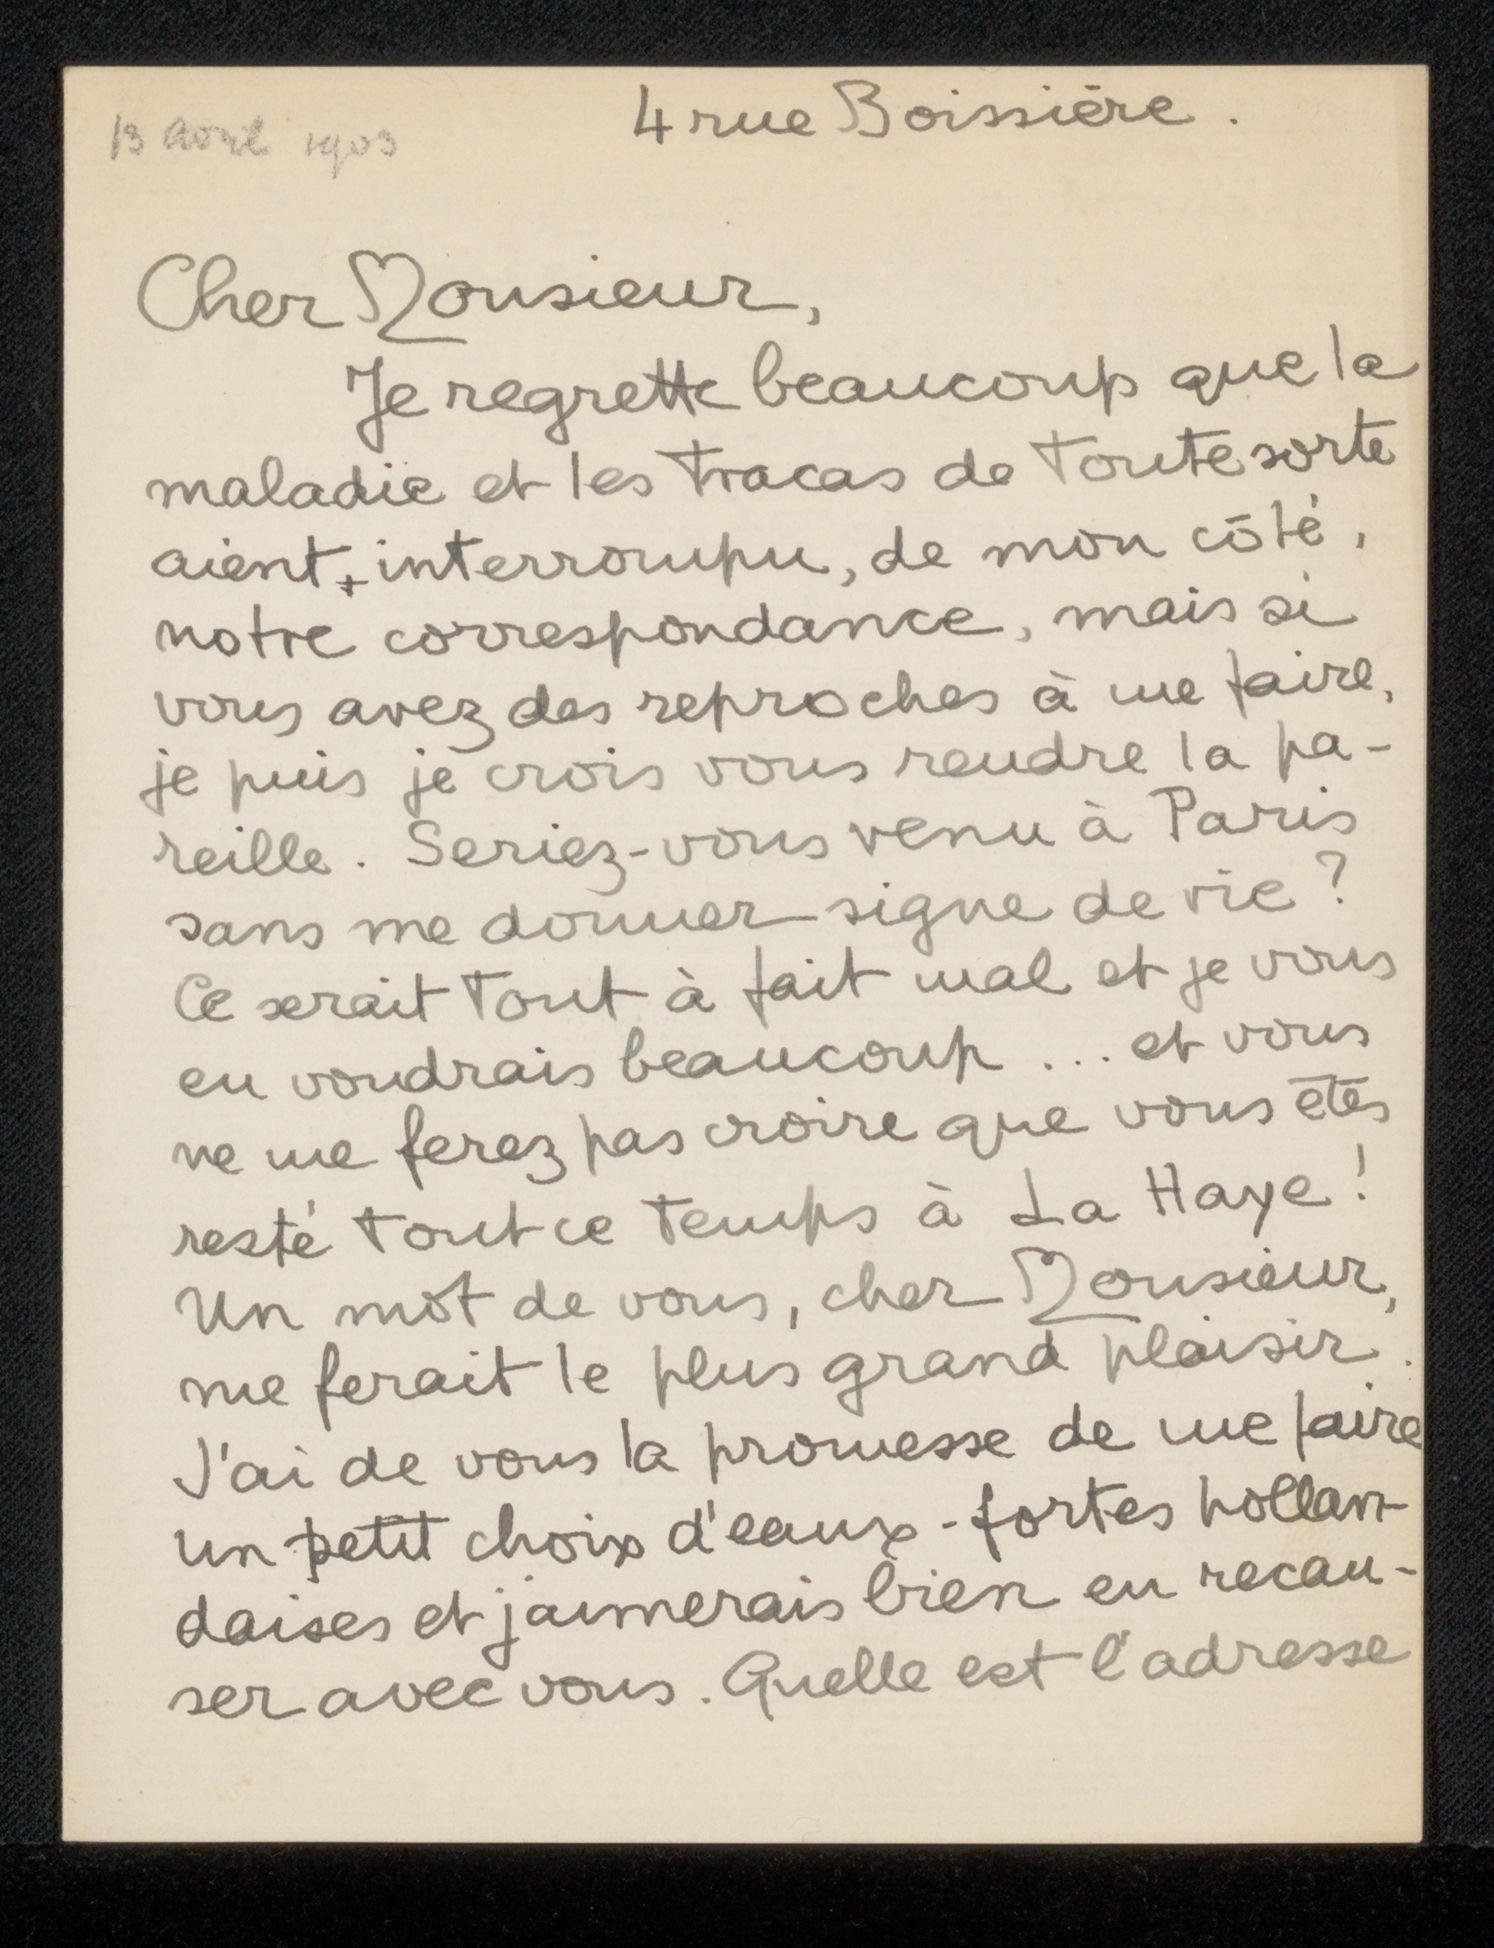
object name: letter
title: Brief aan Philip Zilcken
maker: auguste graaf van gilbert de voisins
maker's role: essayist, schrijver, vertaler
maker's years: 1877-1939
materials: ink, paper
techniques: pen, writing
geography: paris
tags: painter, draughtsman, philip zilcken, the graphic arts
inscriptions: collector's mark: ‘RPK’